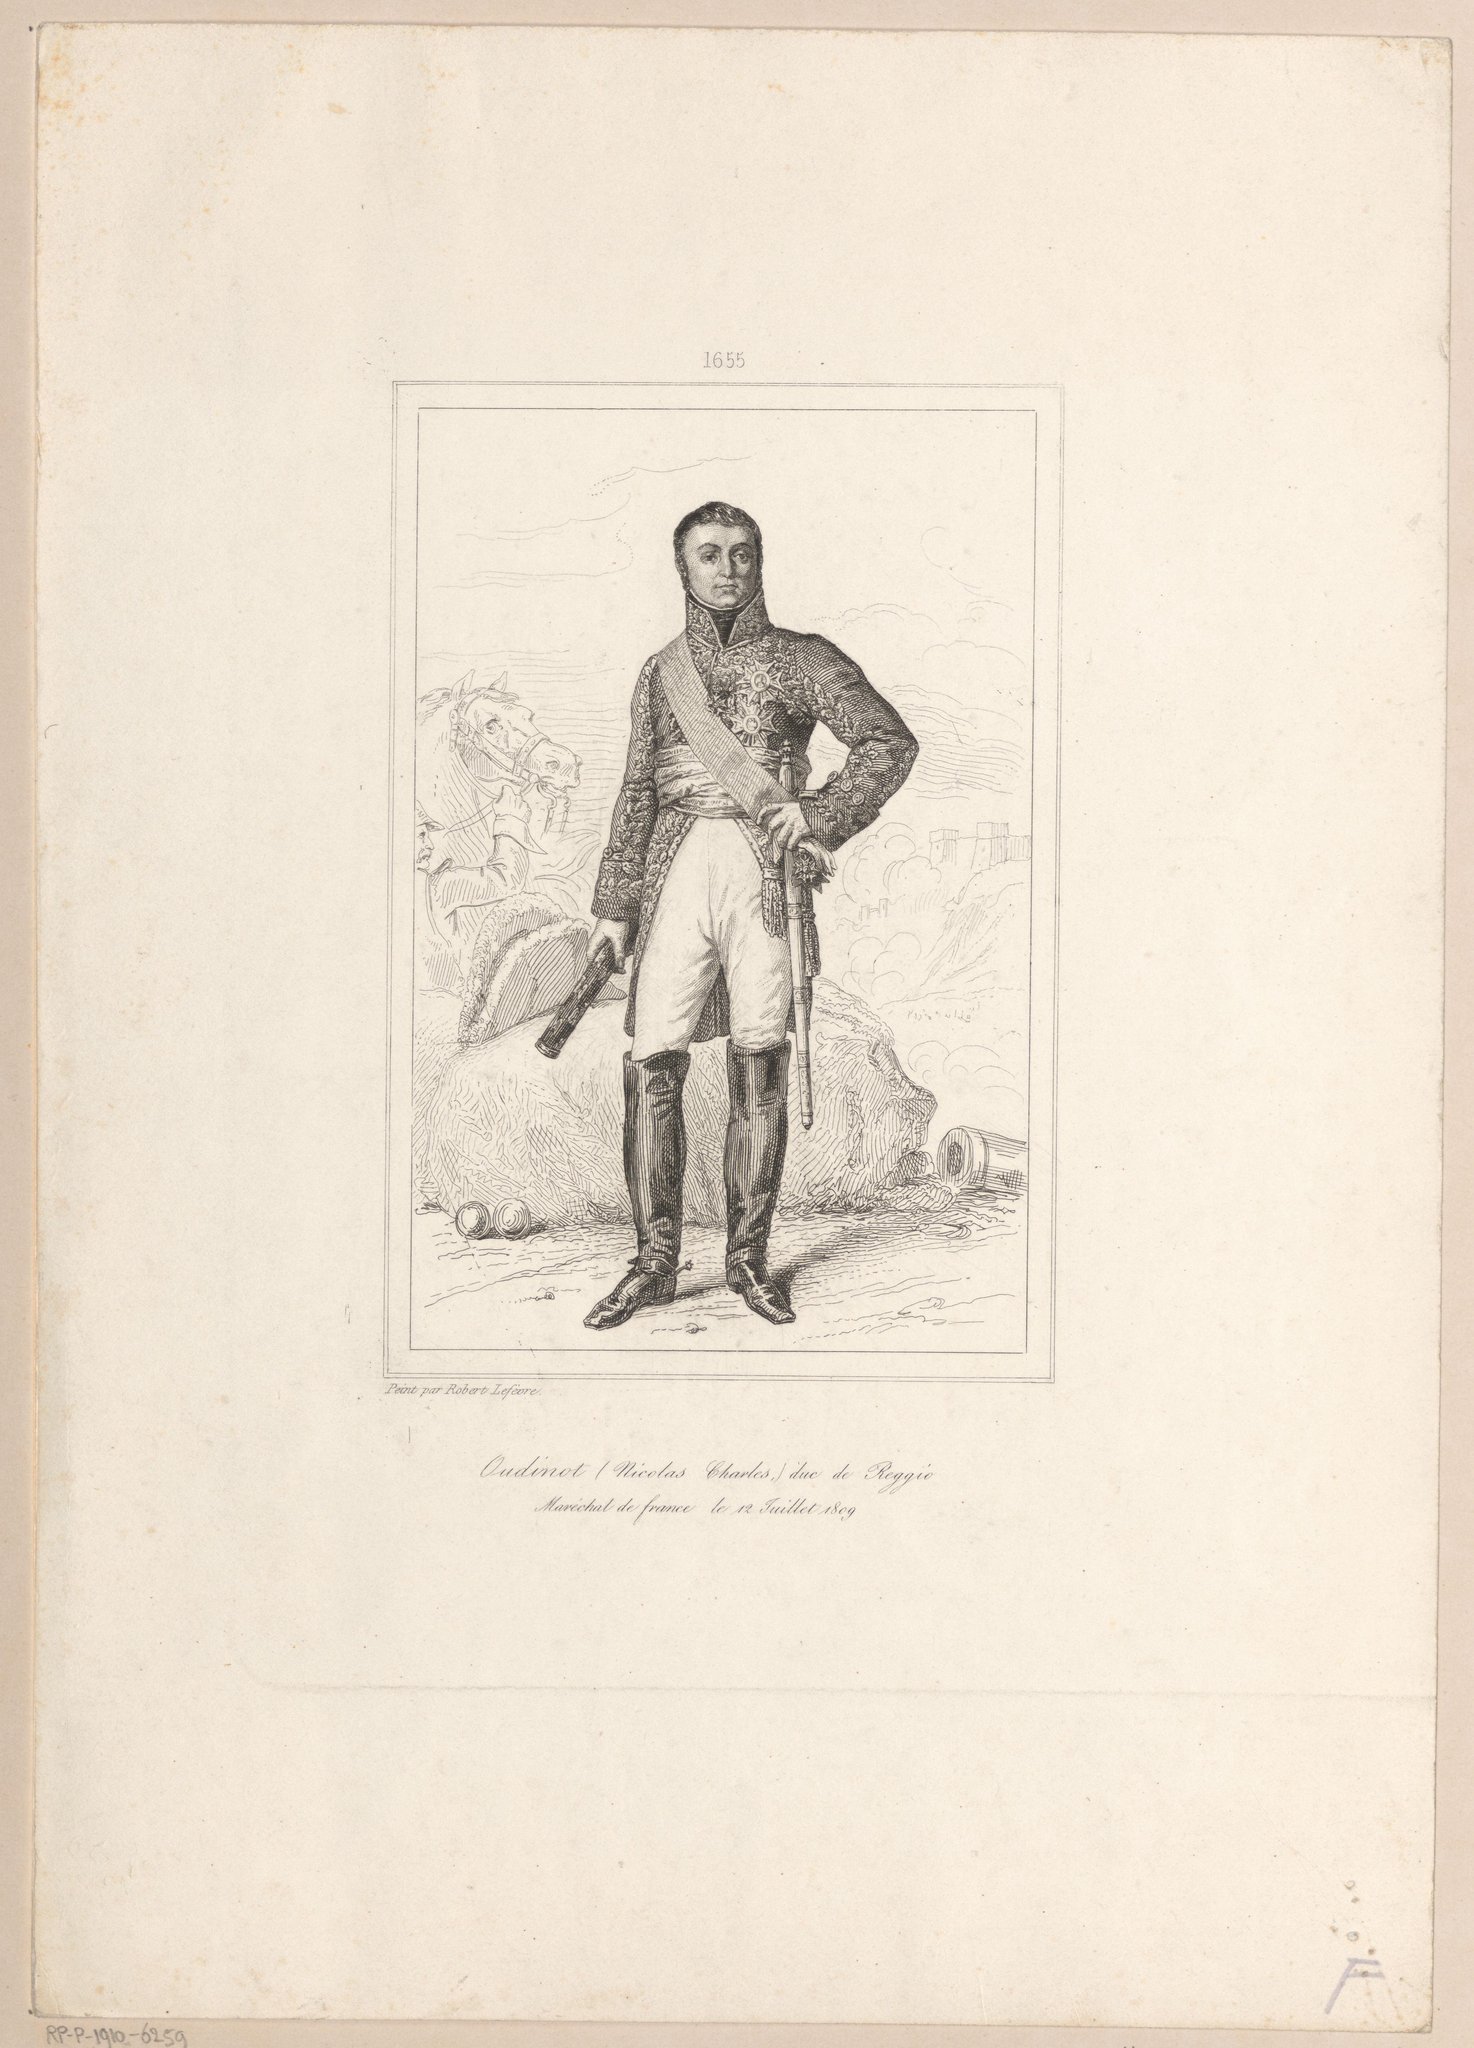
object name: print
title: Portret van Nicolas-Charles-Marie Oudinot, hertog van Reggio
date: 1809-1849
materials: paper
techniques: etching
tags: paris, historical persons - bb - woman, firearms: cannon, medals and other marks of military honour, horse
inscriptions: collector's mark: Lugt 2228